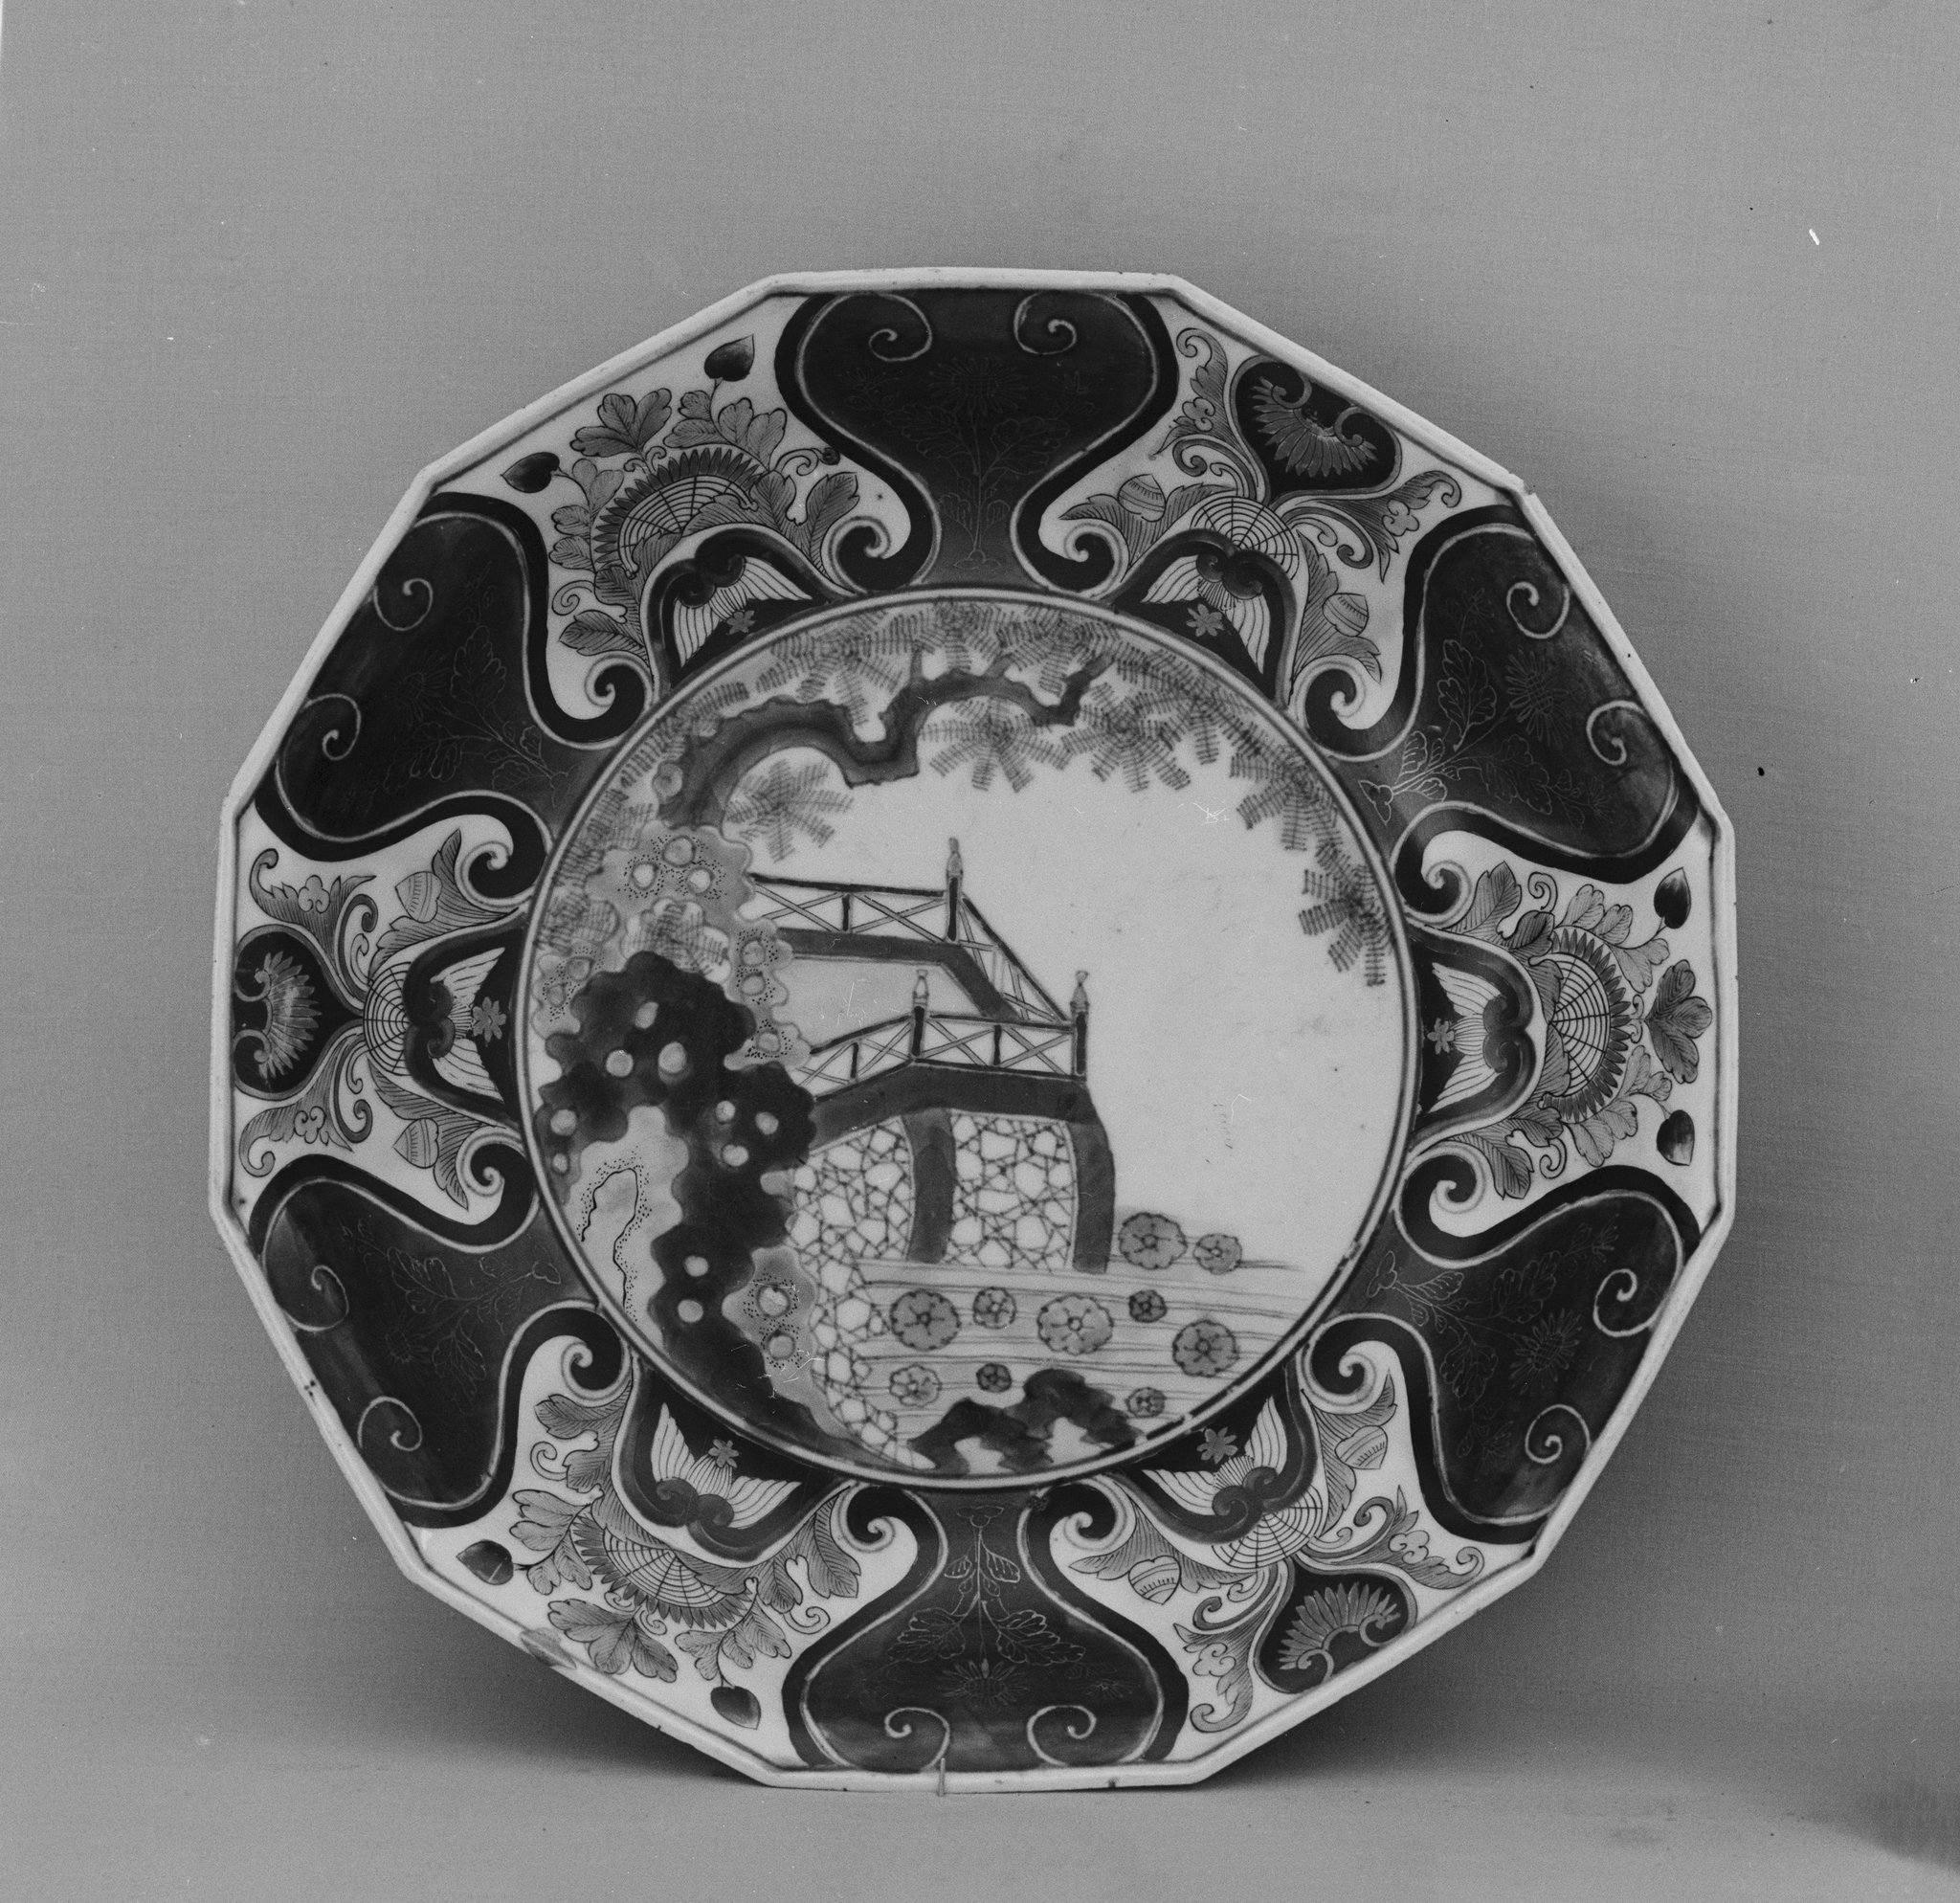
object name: dish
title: Dish with Stone Wall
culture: japanese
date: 1701-1750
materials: enamel, gold, porcelain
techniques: overglaze, polychrome, underglaze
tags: trees